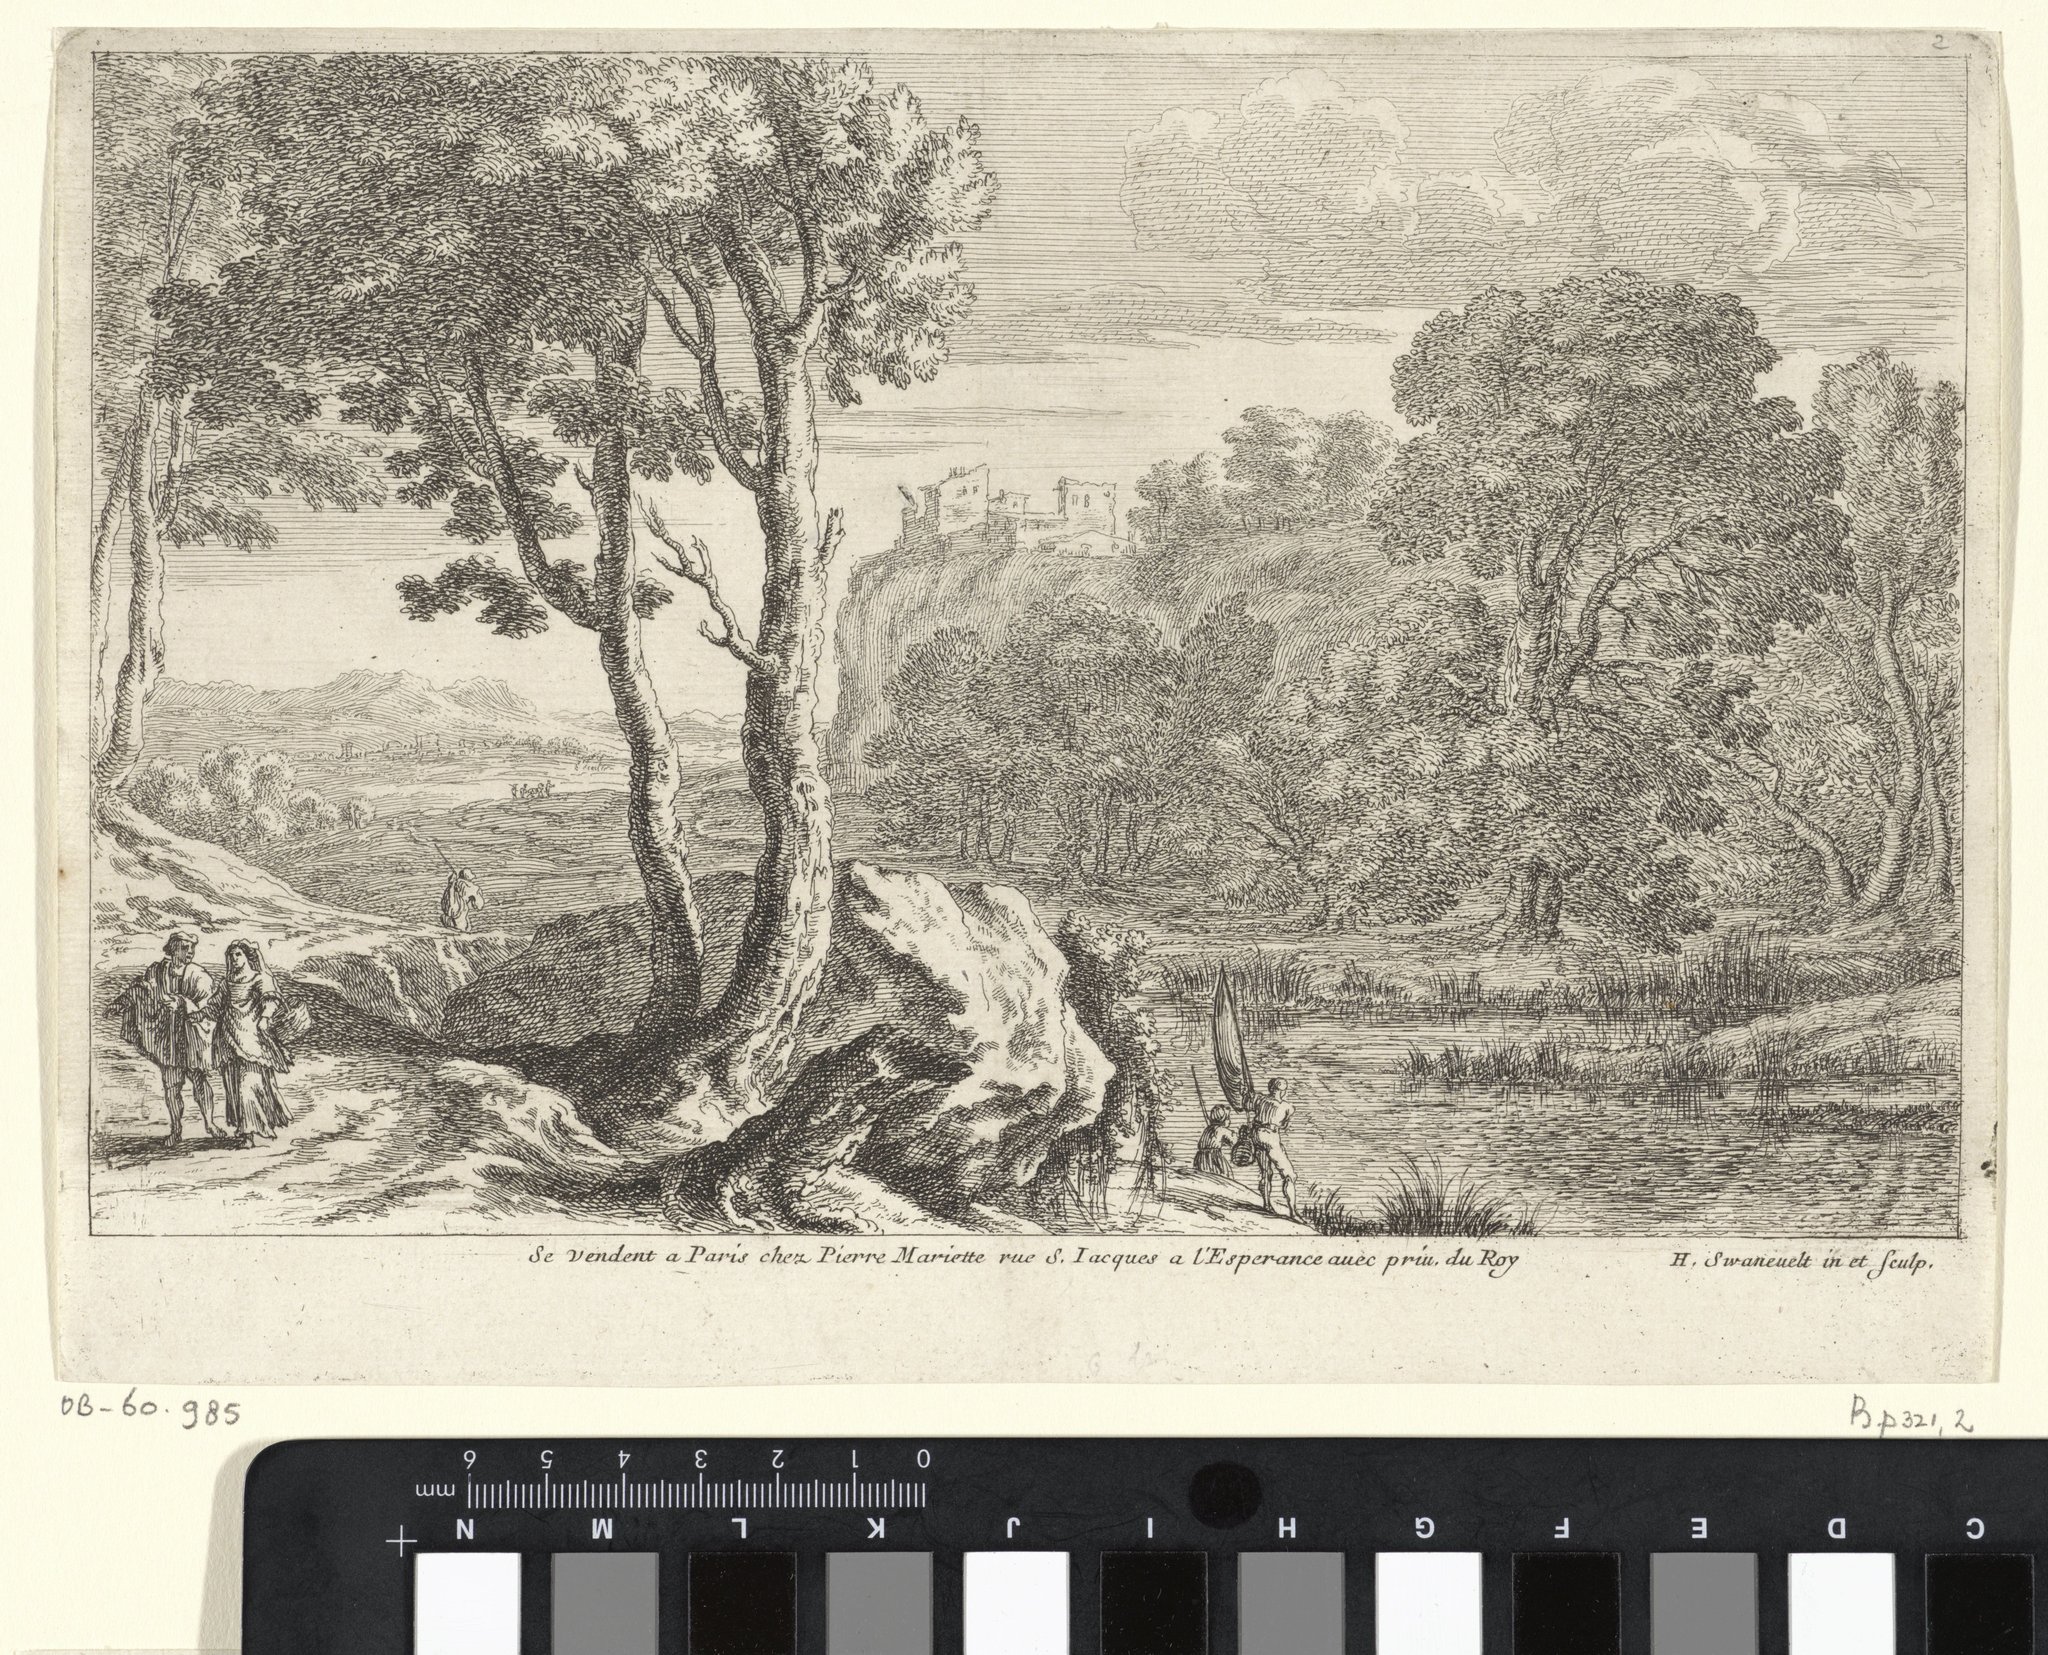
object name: print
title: Twee landschappen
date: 1633-1657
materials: paper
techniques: etching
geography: paris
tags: rural housing, e.g. country-house, villa, cottage, (high) hill, river mouth, estuary, 'en route', traveller under way, angling, rocks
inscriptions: collector's mark: Lugt 2228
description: Aan de oever van een rivier staan twee vissers. Op het pad langs de rivier wandelen enkele figuren en rechts in de verte ligt een gebouw op rots.